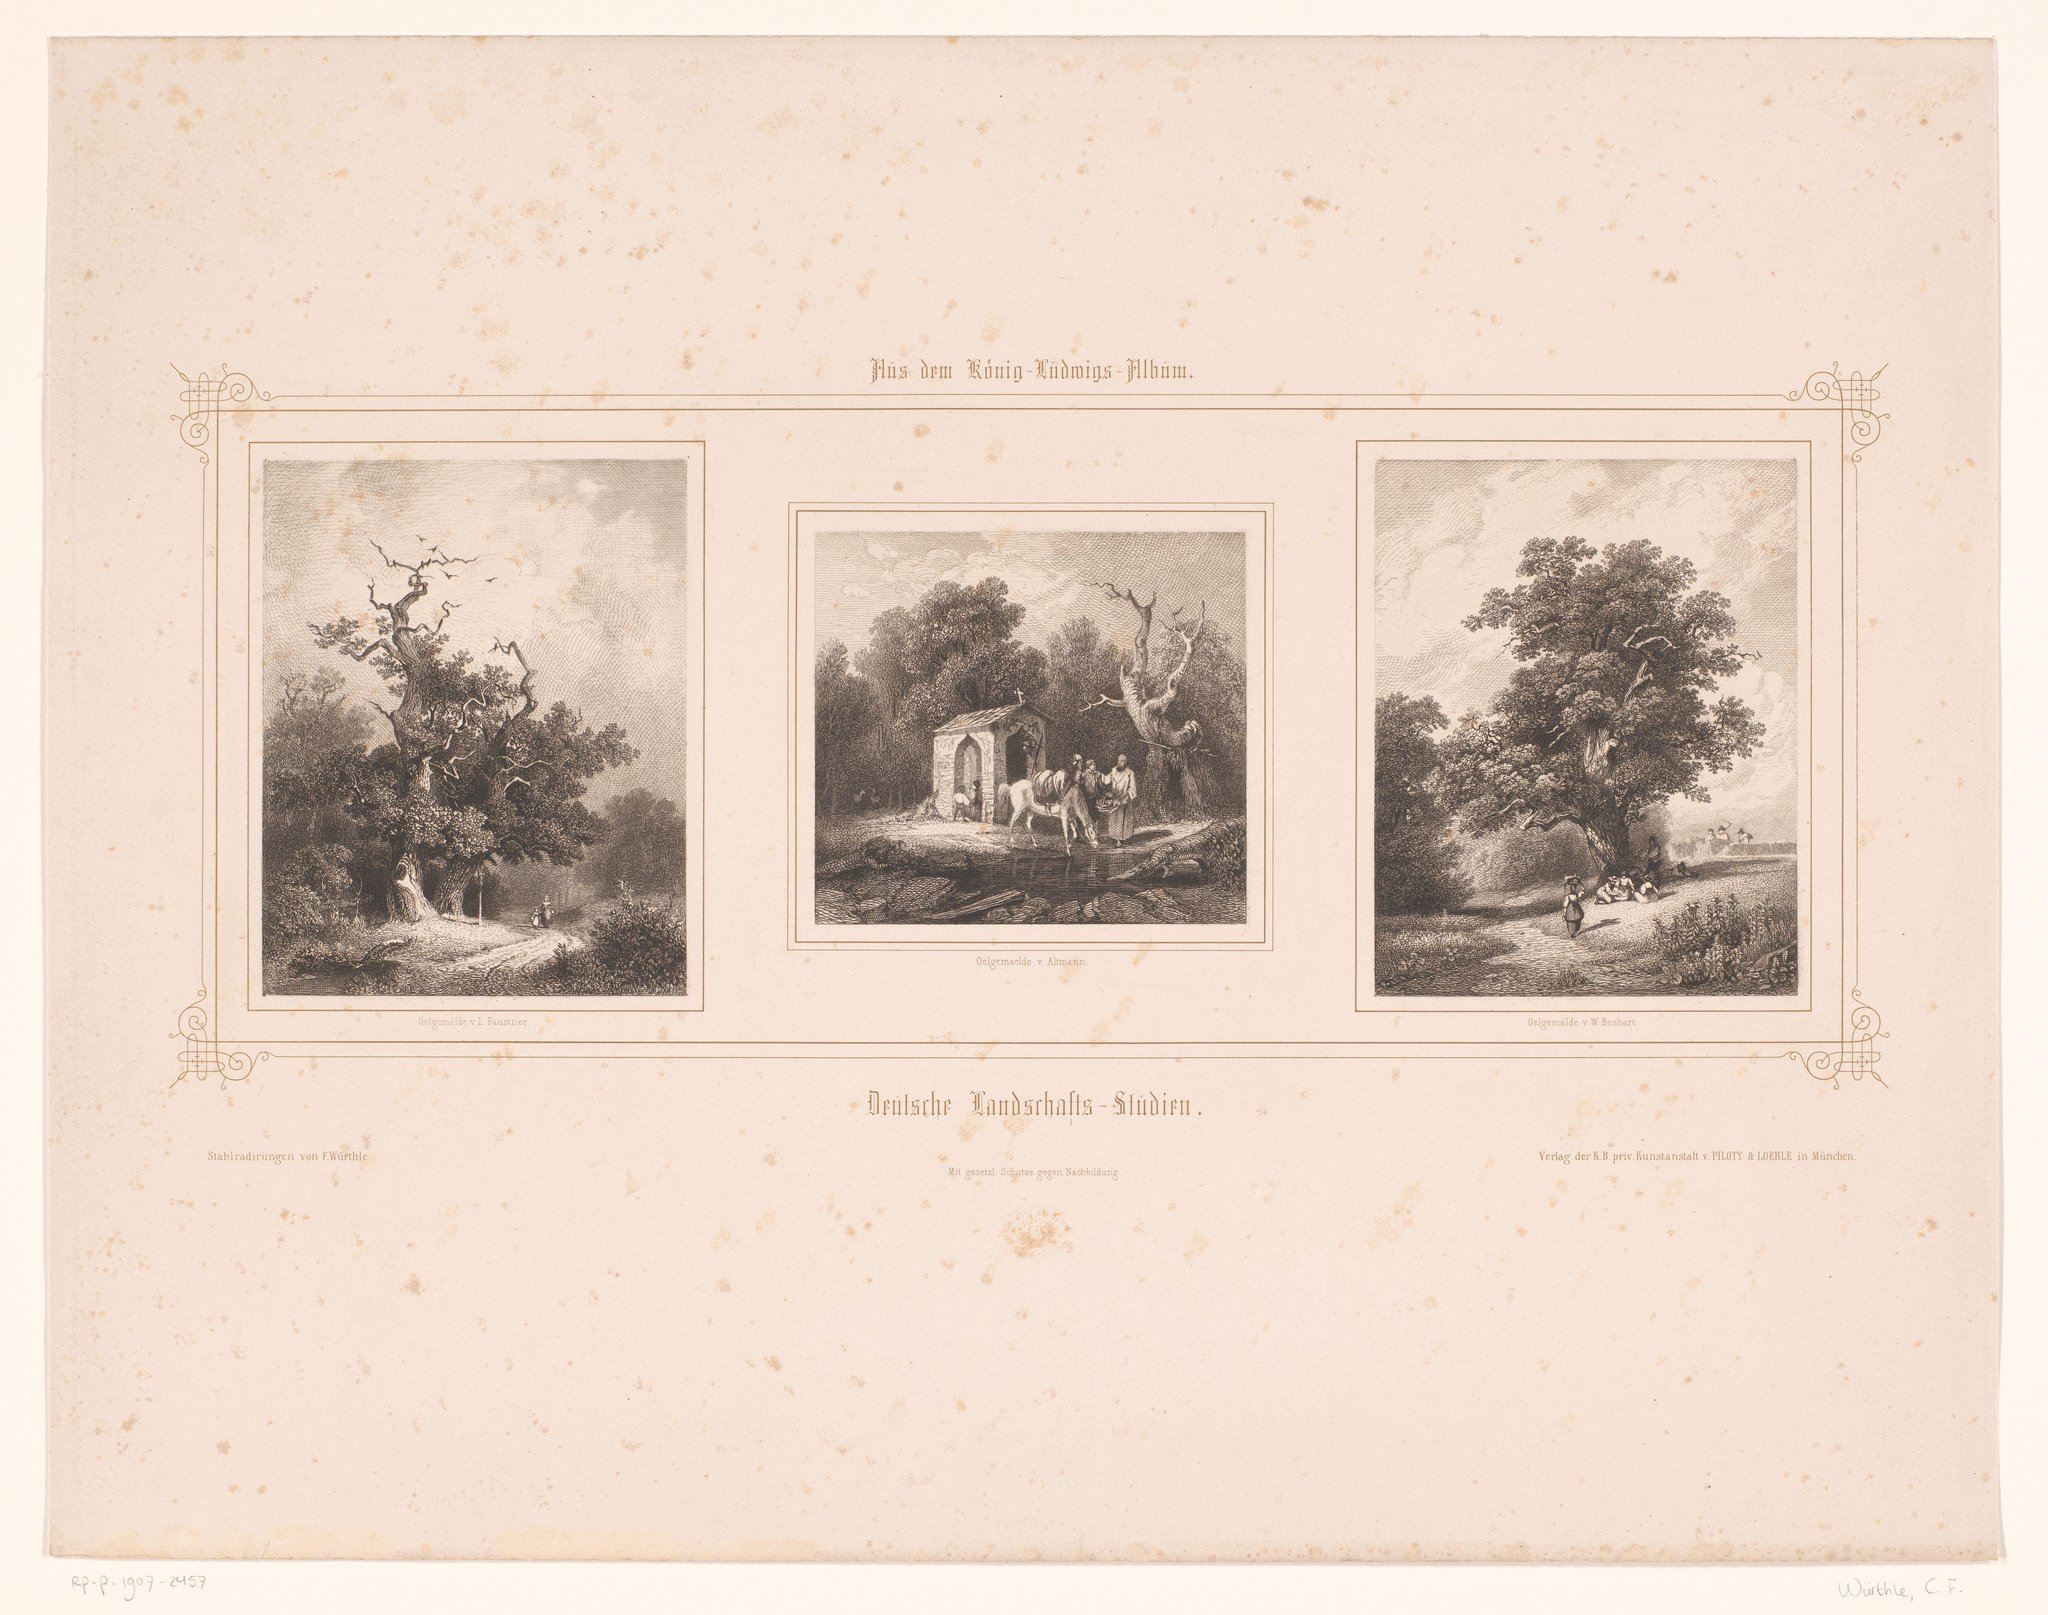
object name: print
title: Deutsche Landschafts-Studien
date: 1850-1859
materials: paper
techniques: lithograph, roulette, engraving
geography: munich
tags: lodewijk i (koning van beieren), landscapes, (traveller) resting in the open air, 'en route', traveller under way, ploughing, germany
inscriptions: check stamp: ‘Piloty & Loehle München’, collector's mark: Lugt 2228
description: Prent afkomstig uit de serie 'Album Seiner Majestät des Königs Ludwig I. von Bayern', verschenen in verschillende afleveringen. De prenten gaan terug op het album dat Lodewijk I van Beieren op 9 oktober 1850 kreeg overhandigd van verschillende kunstenaars.